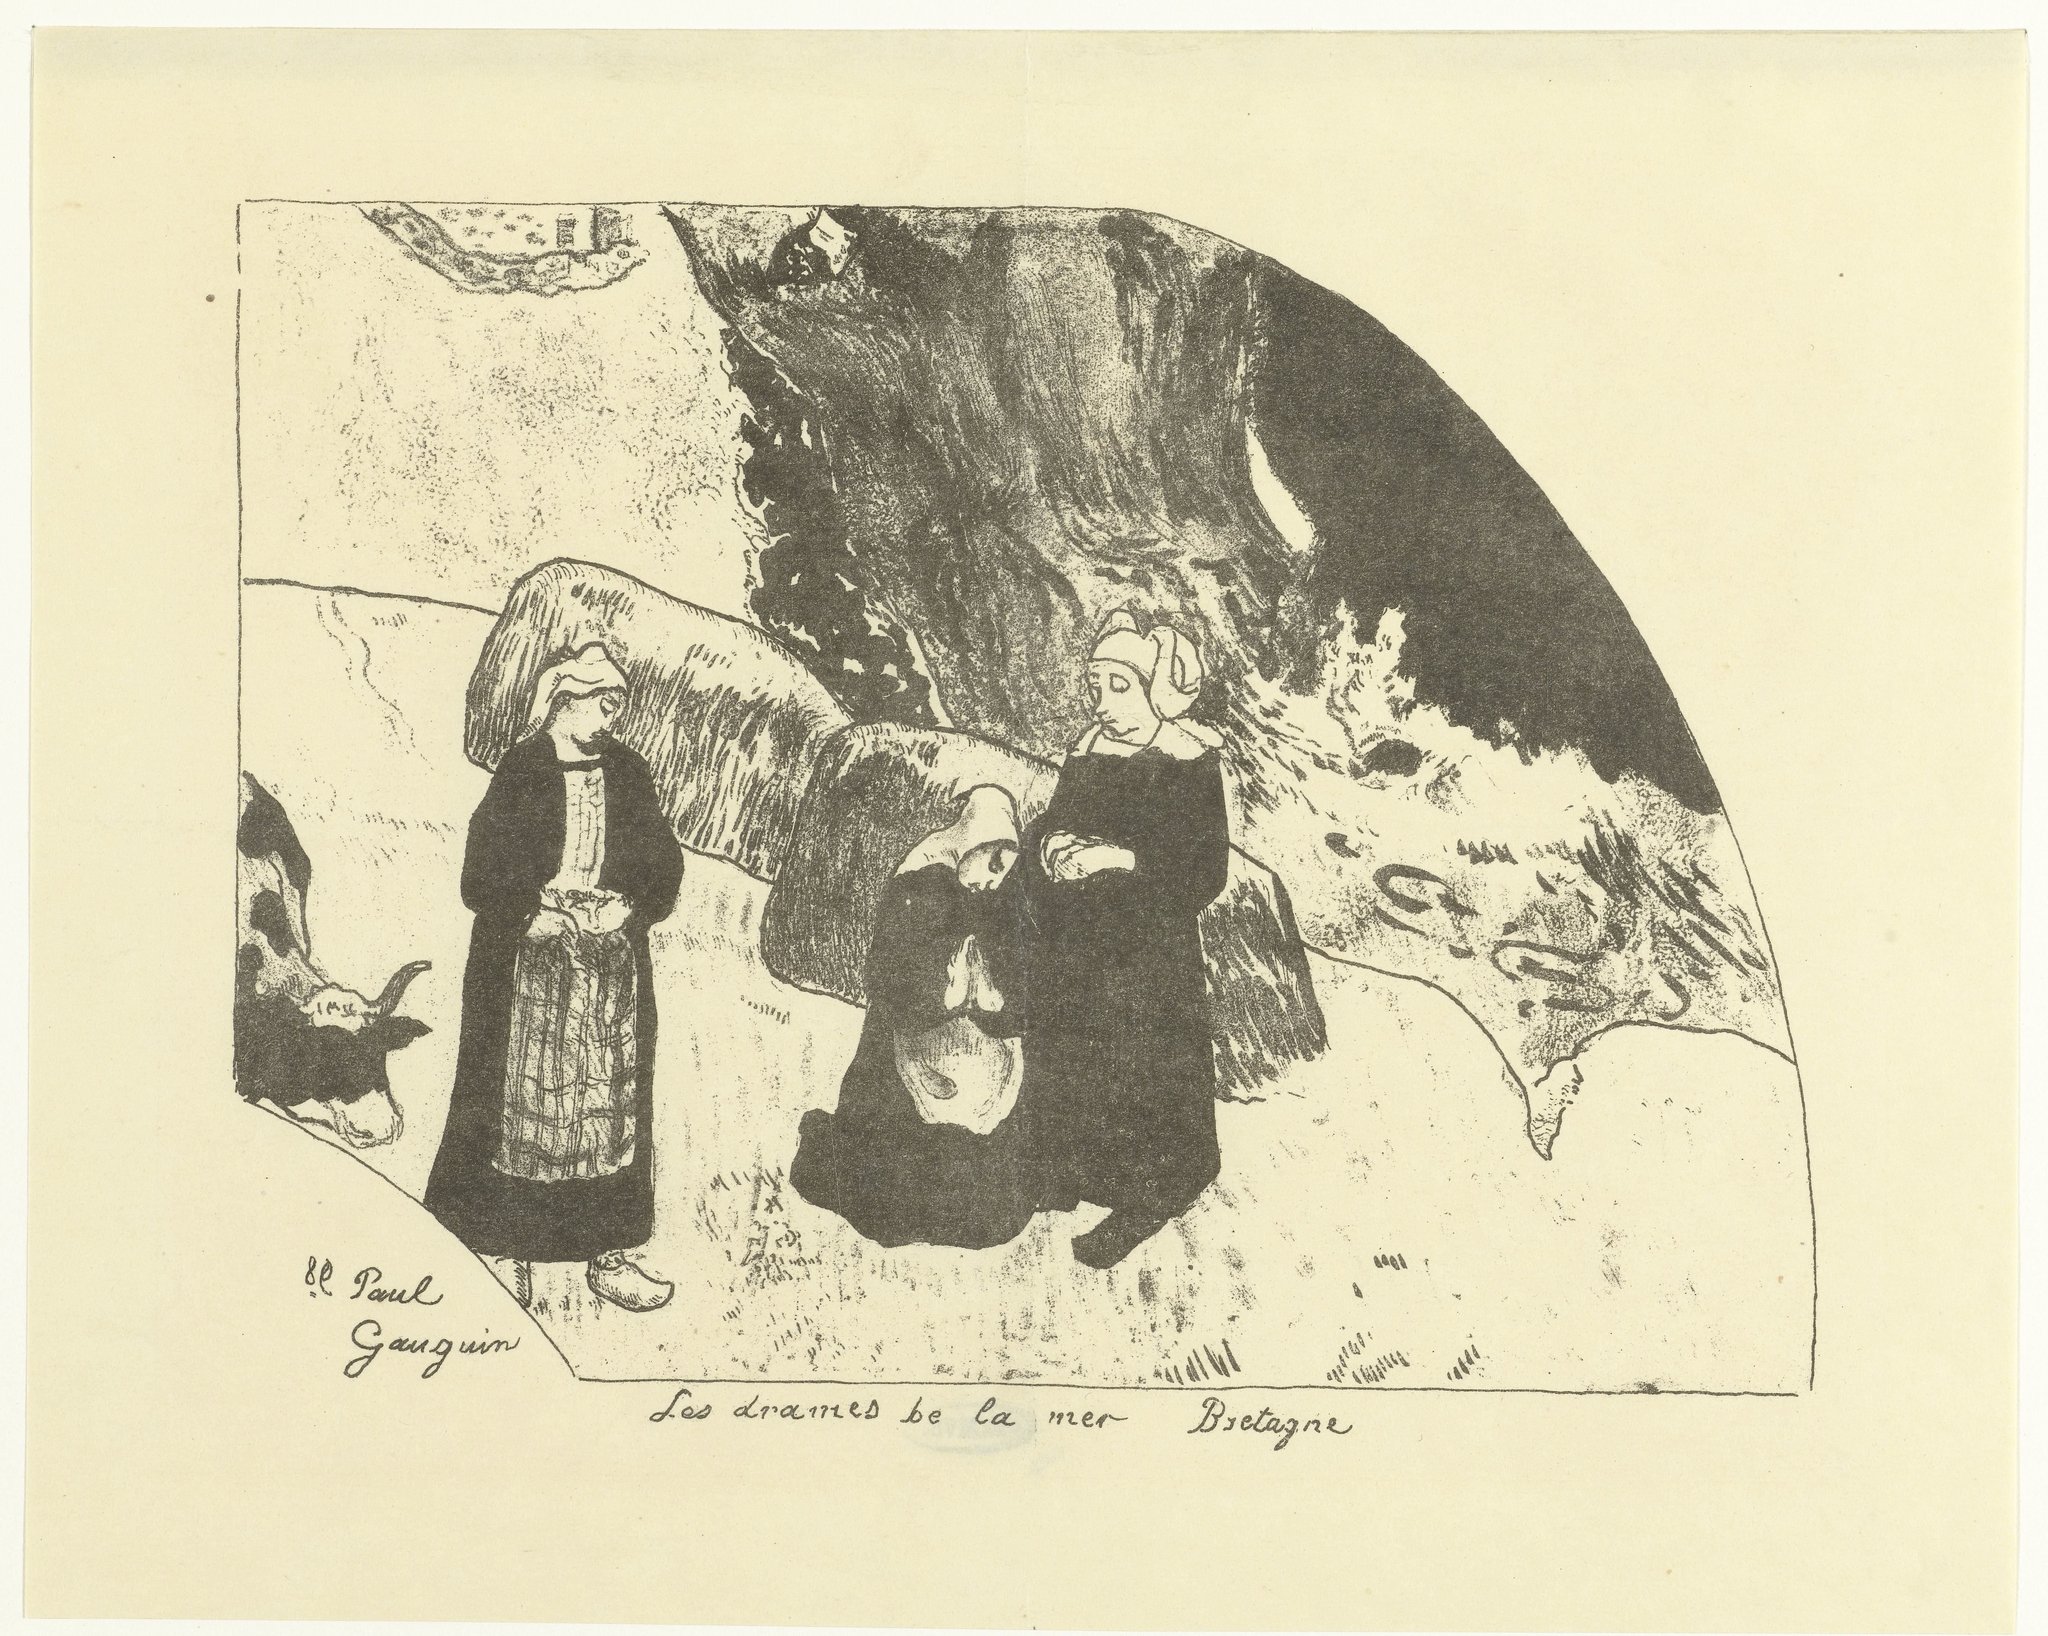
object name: print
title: Verschrikkingen van de zee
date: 1889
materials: paper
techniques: lithography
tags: bretagne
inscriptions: collector's mark: Lugt 2228, collector's mark: Lugt 2760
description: Deze prent werd na 1900 gepubliceerd door Ambroise Vollard in een oplage van ongeveer vijftig exemplaren.